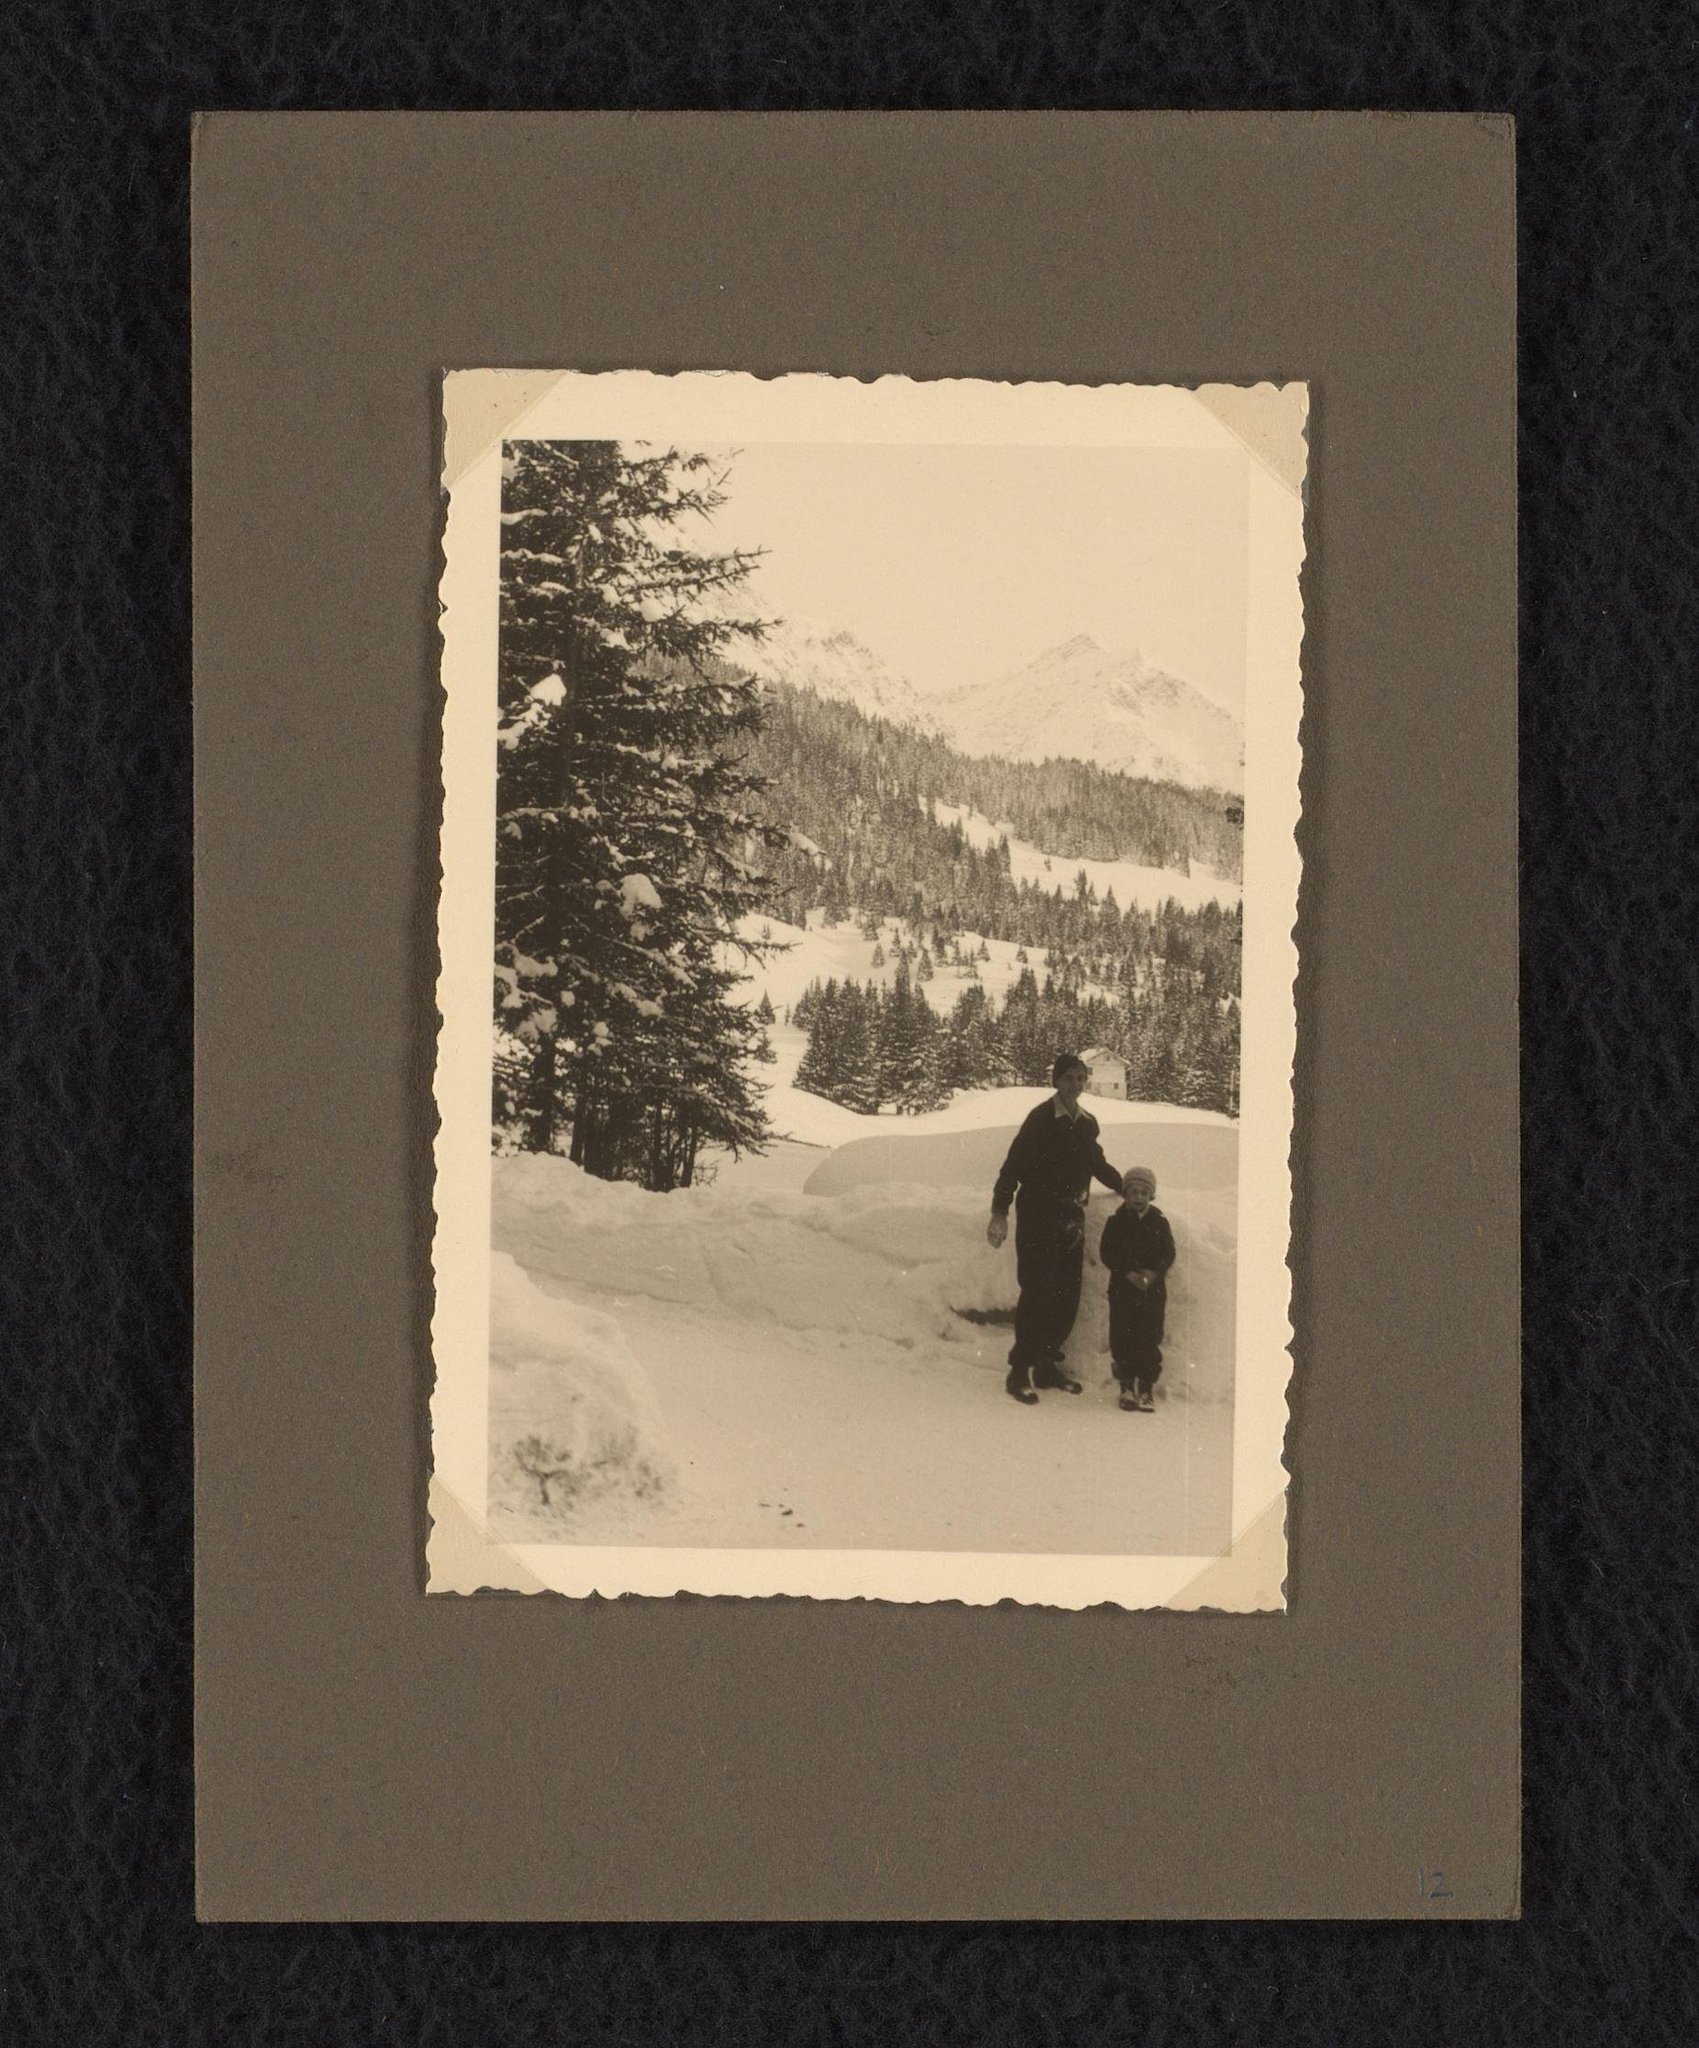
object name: album leaf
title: Isabel en een onbekende vrouw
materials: cardboard, photographic support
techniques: gelatin silver print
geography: lenzerheide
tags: leiden, isabel wachenheimer-elon, the family travelling, on holiday, snow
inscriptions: date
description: Albumblad met een foto van Isabel Wachenheimer en een onbekende vrouw in de sneeuw. Onderdeel van het fotoalbum met vakantiefoto's Lenzerheide, 1934.